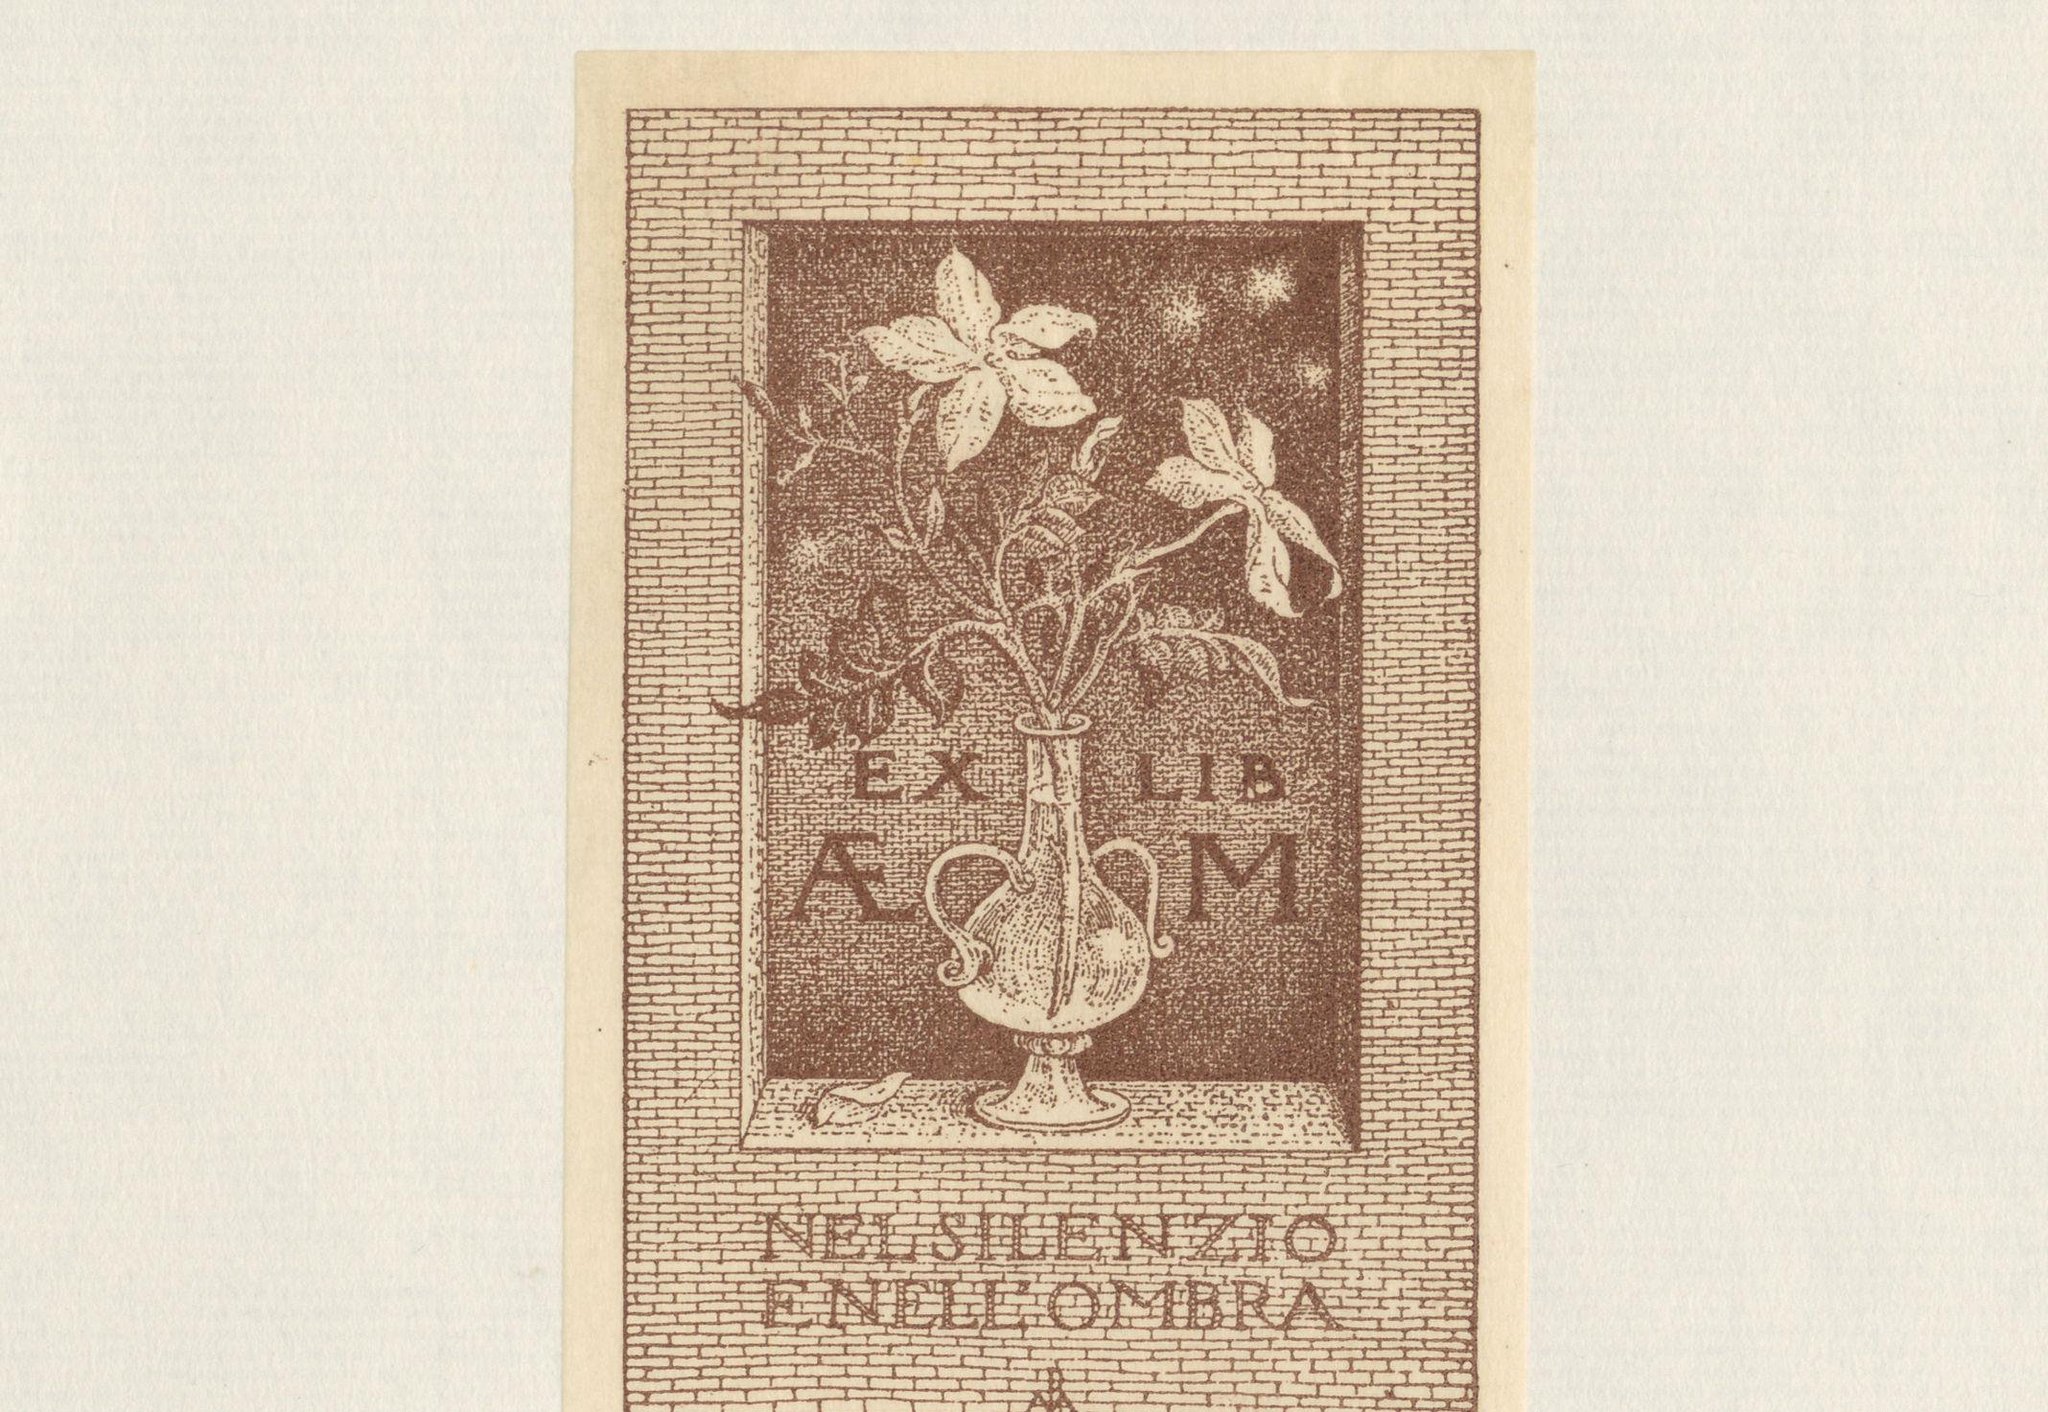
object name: bookplate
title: Nel silenzio e nell'ombra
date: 1900-1999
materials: paper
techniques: printing block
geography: italy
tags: stars, open window, flowers in a vase